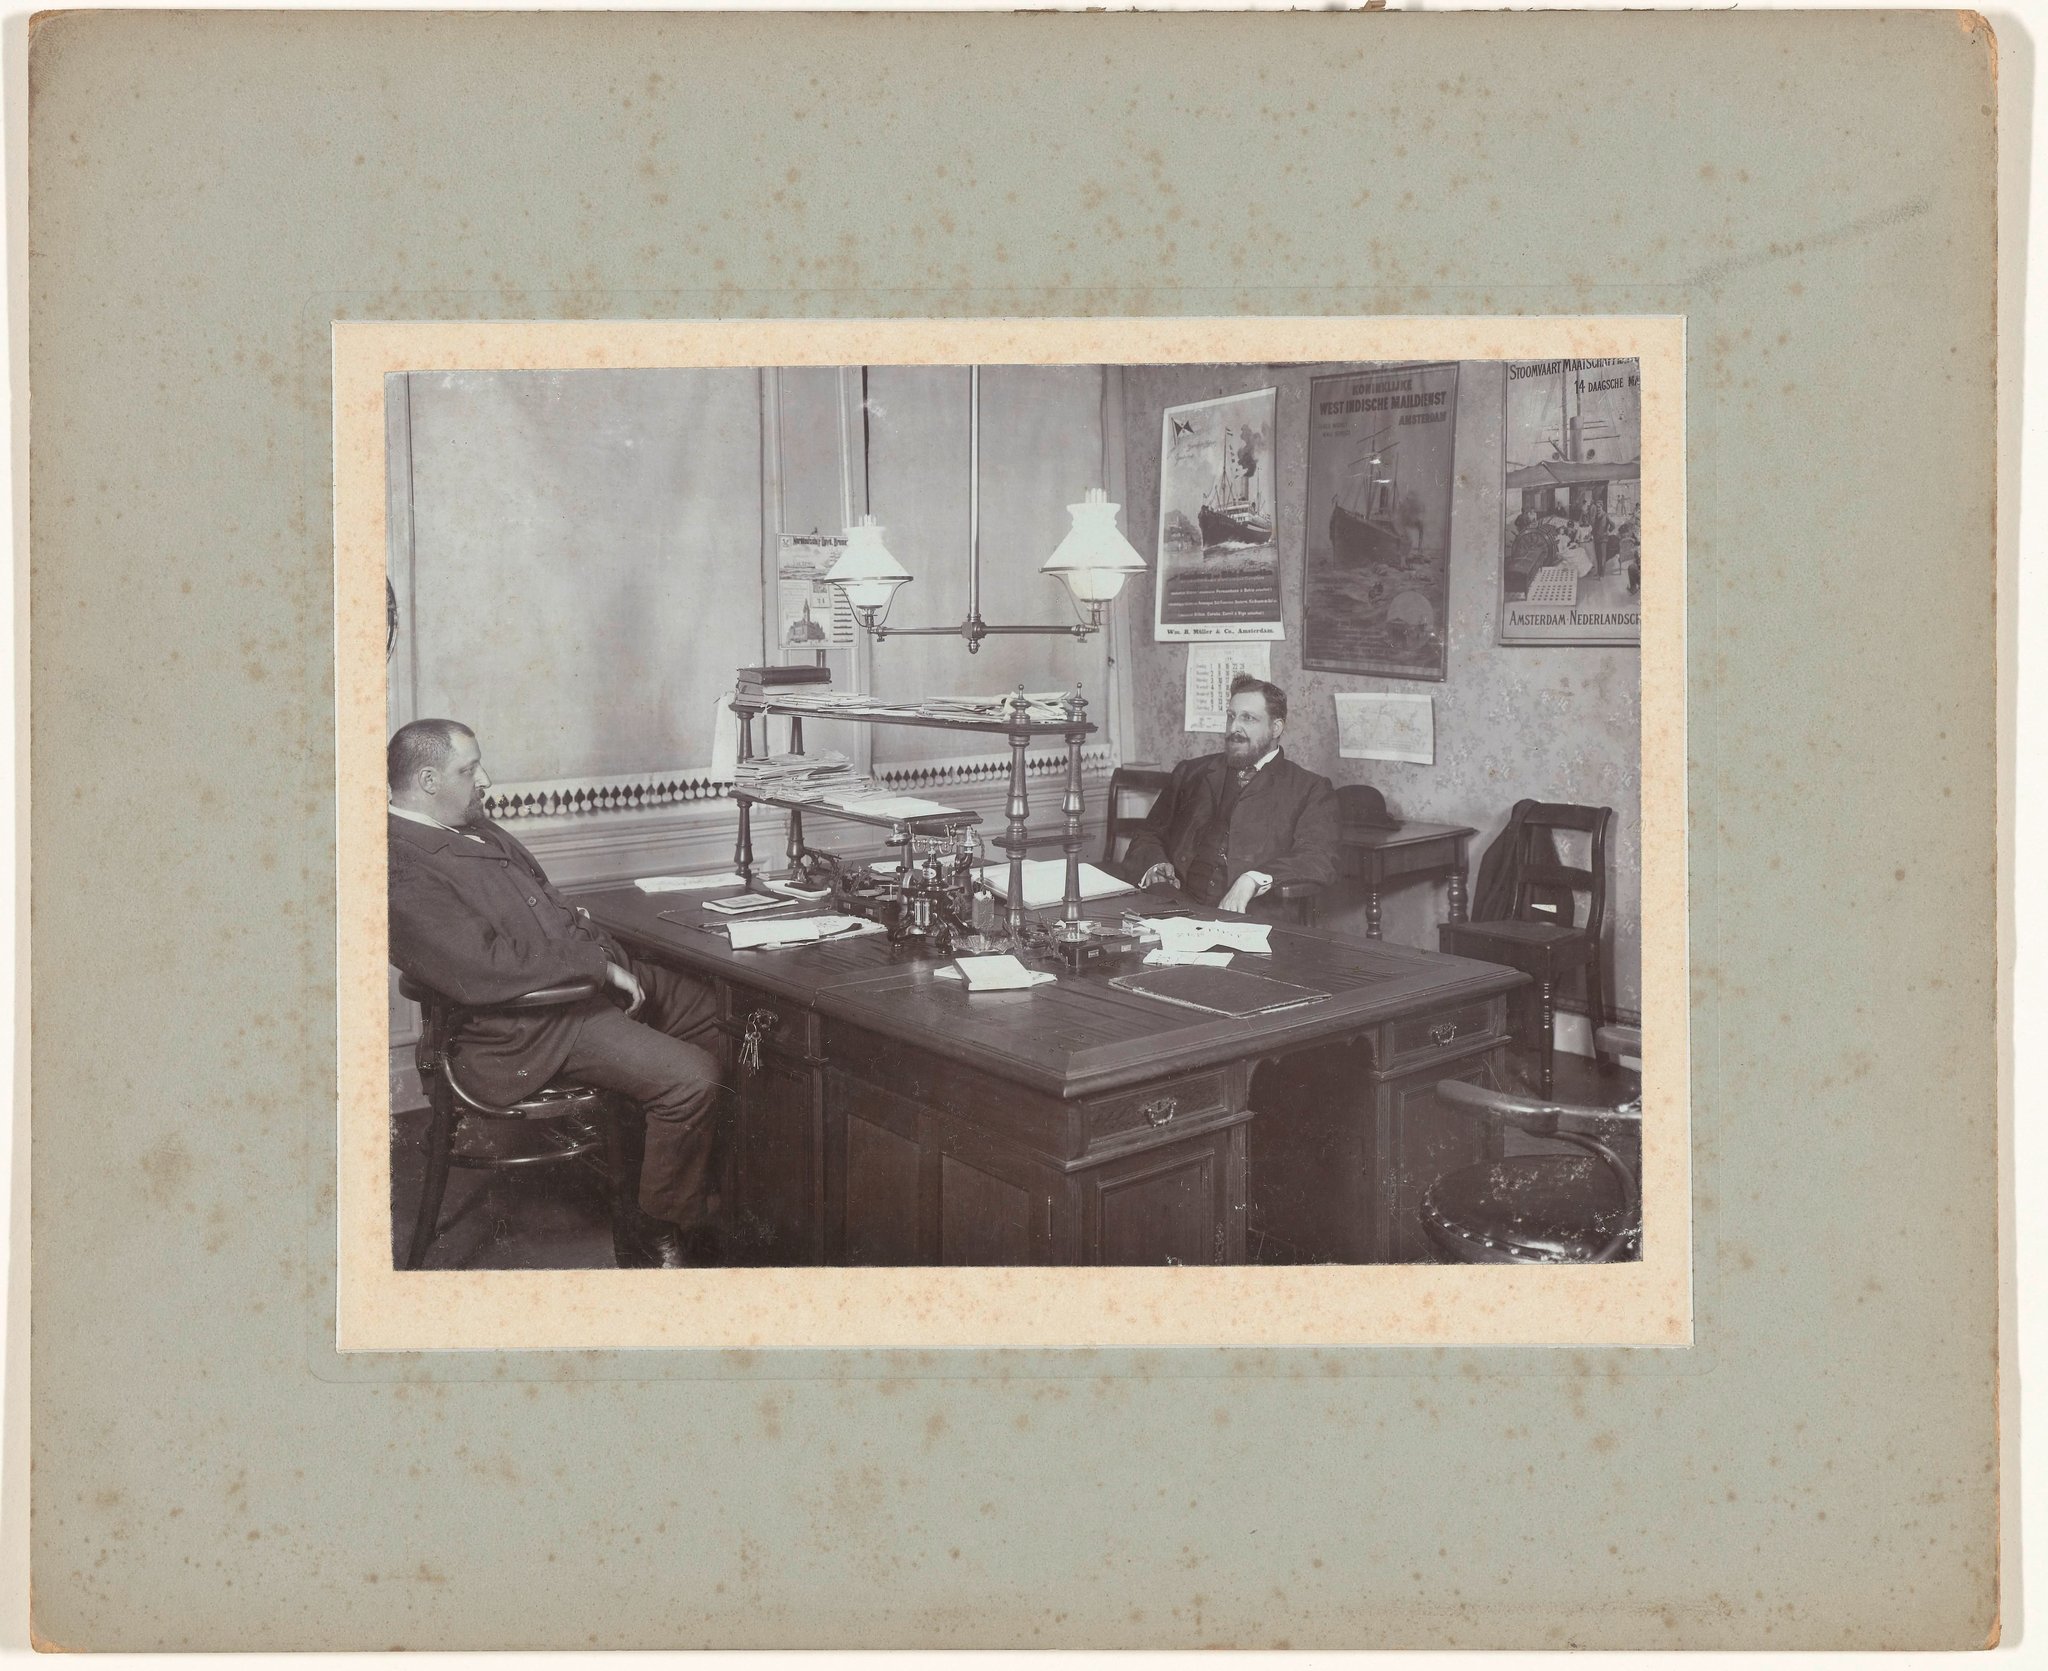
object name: photograph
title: Twee klerken op een scheepvaartkantoor, Amsterdam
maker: nicolaas schuitvlot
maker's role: fotograaf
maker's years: 1859-1947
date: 1900-1920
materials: paper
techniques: collodion silver print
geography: amsterdam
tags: office (~ administration), amsterdam